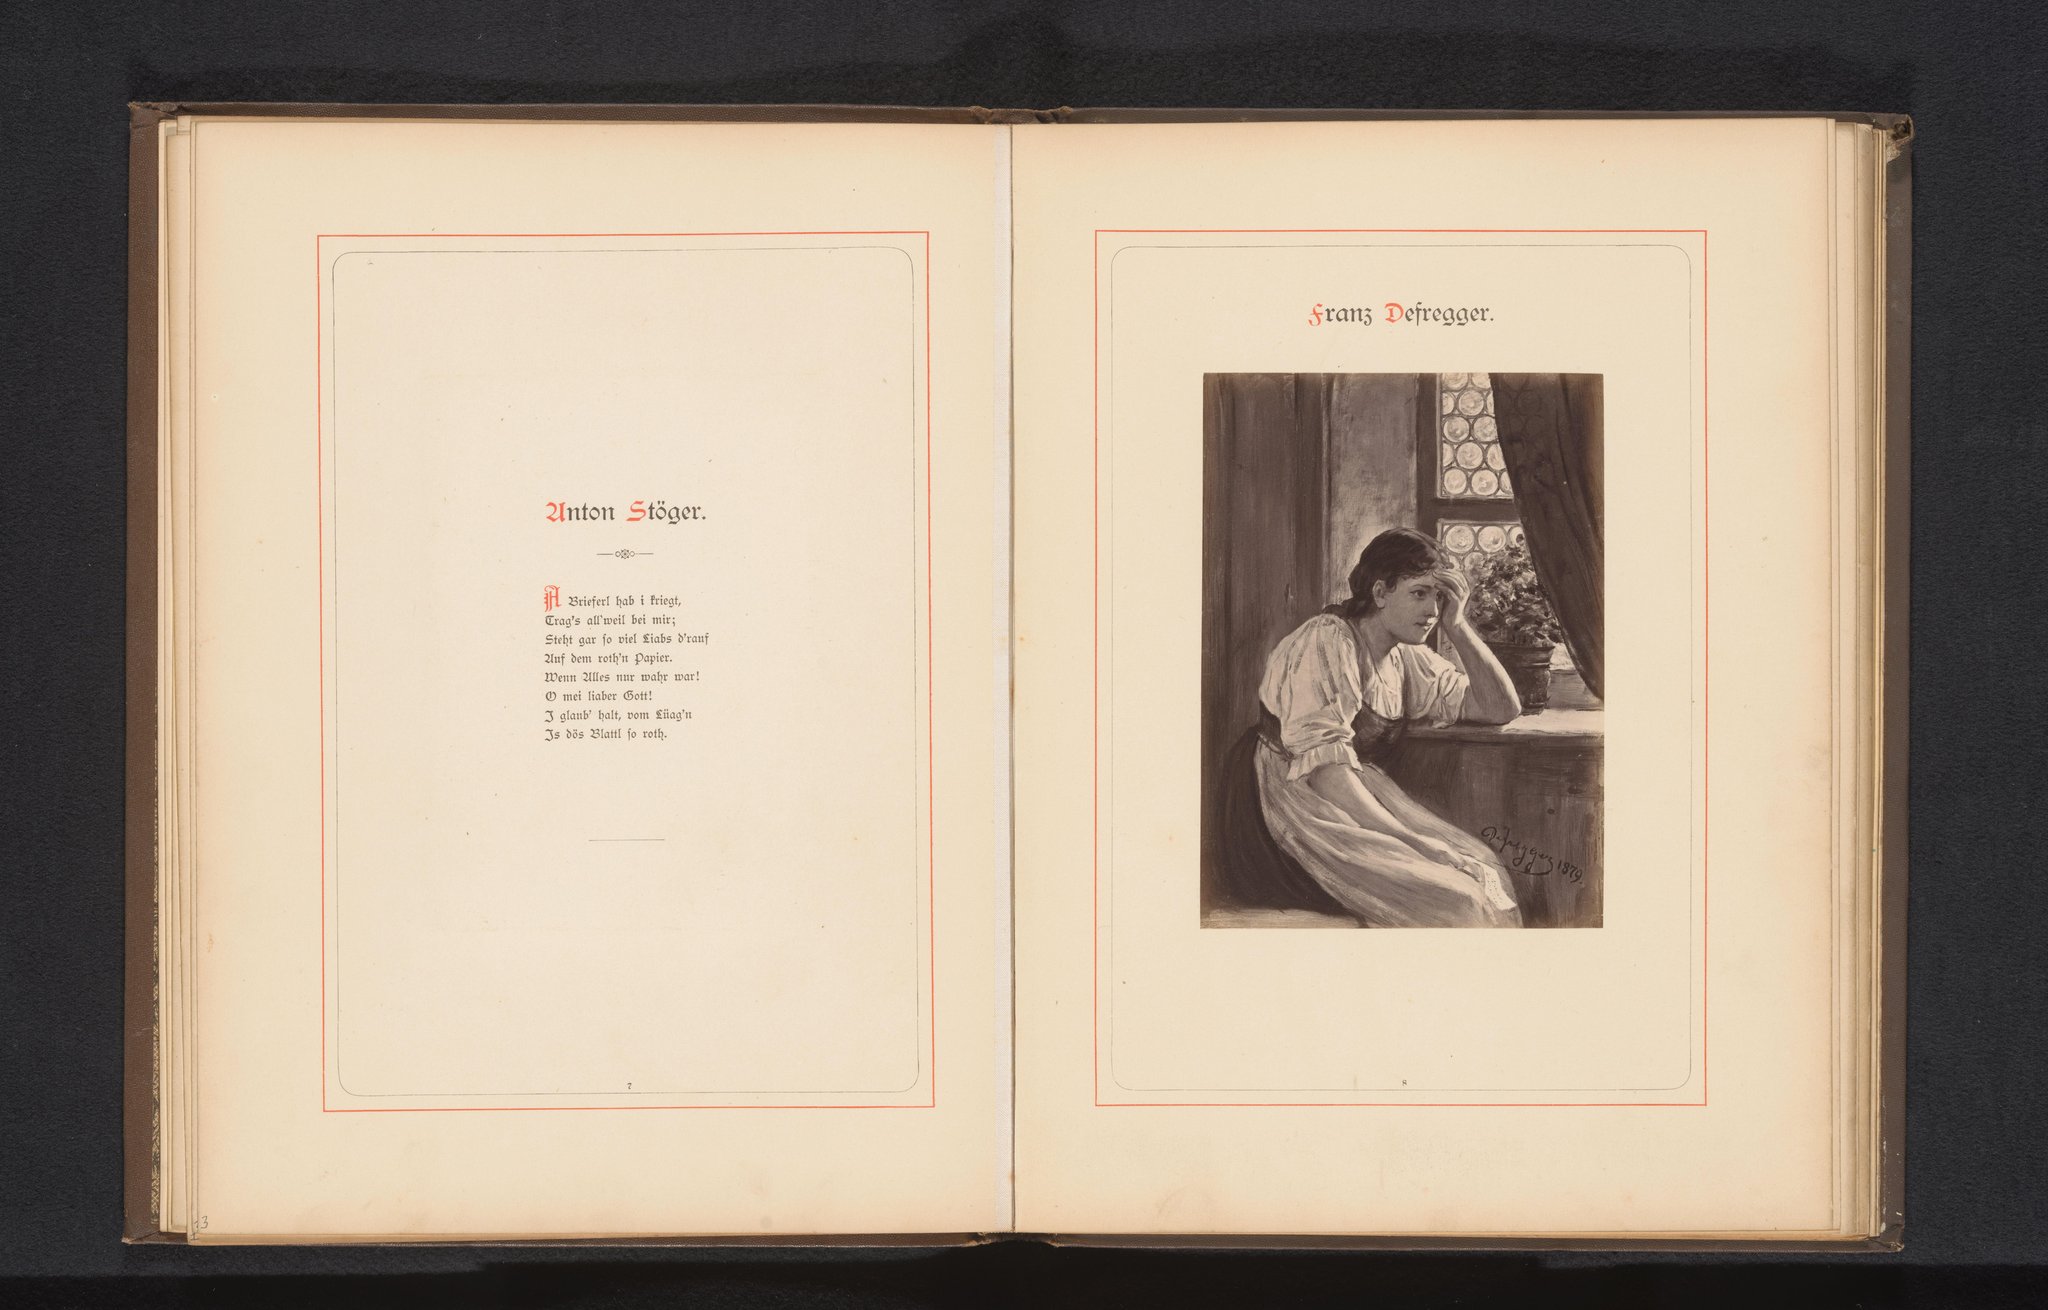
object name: page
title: Franz Defregger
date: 1879-1885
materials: photographic support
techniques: albumen print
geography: munich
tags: adolescent, young woman, maiden, picture, painting, closed window